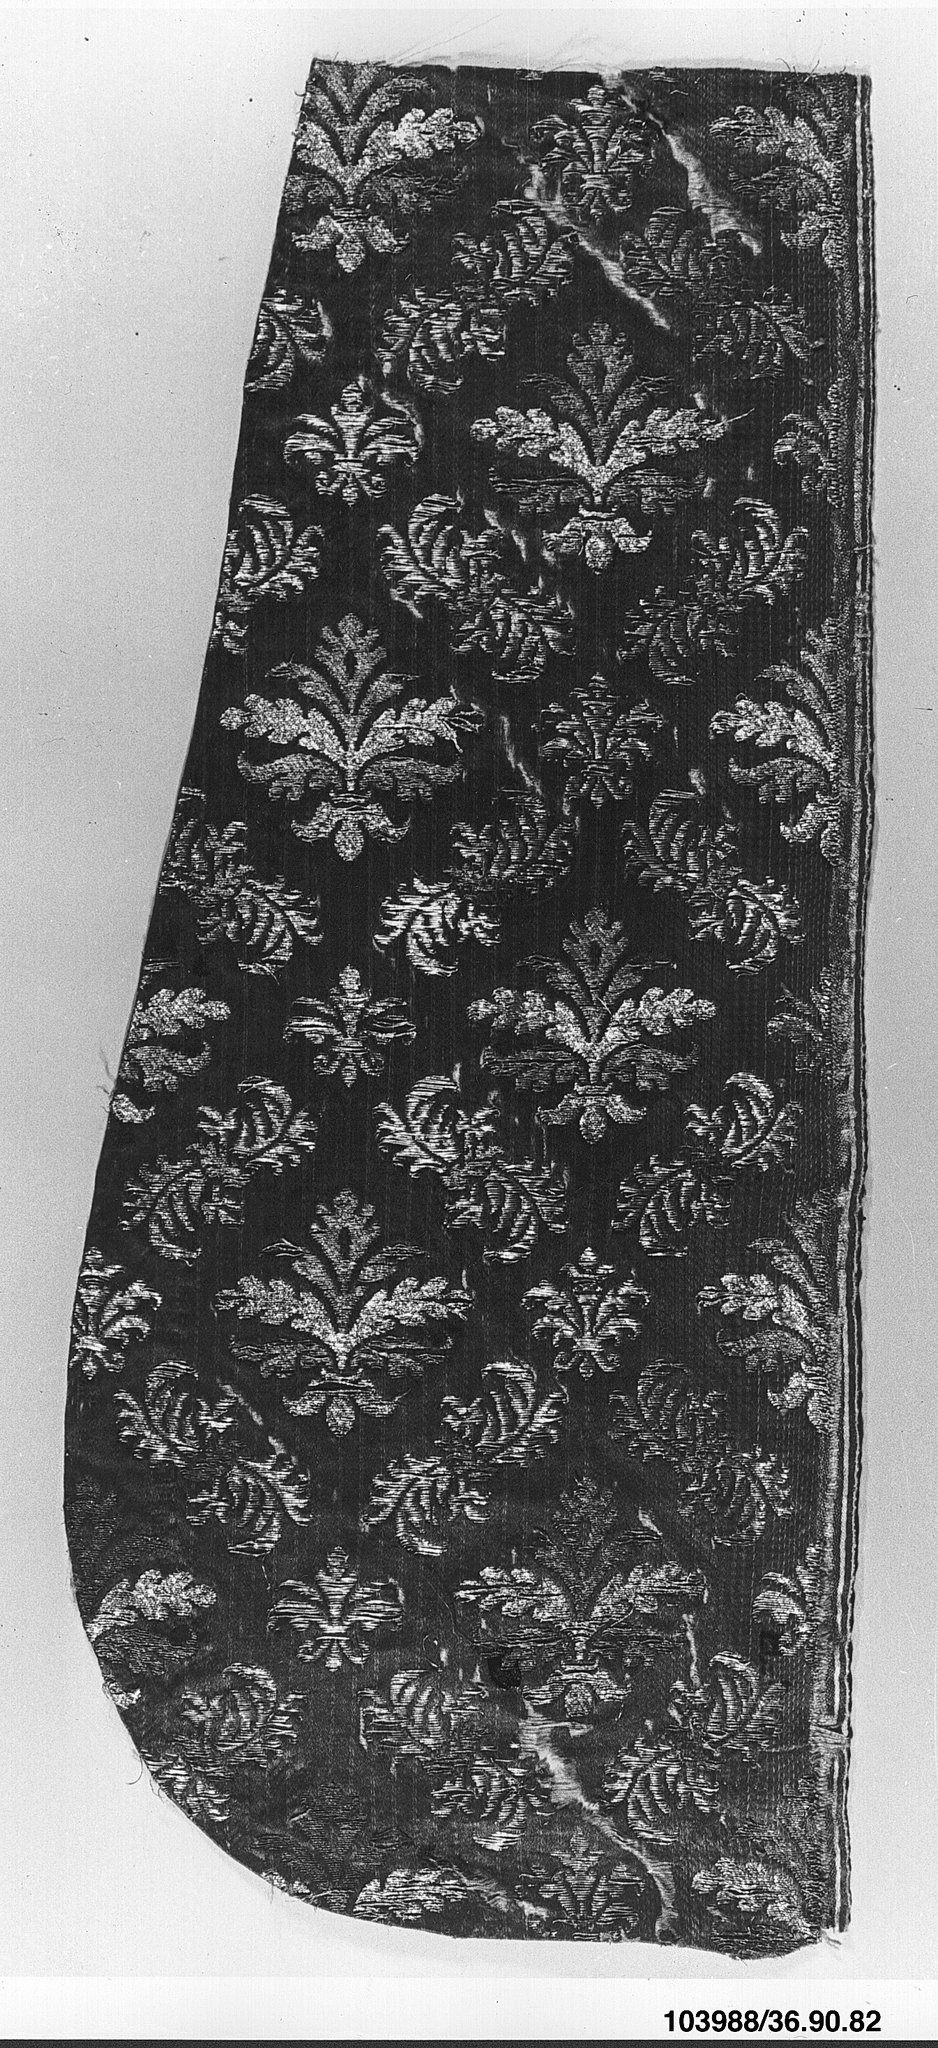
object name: piece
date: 1501-1700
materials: metal thread, silk